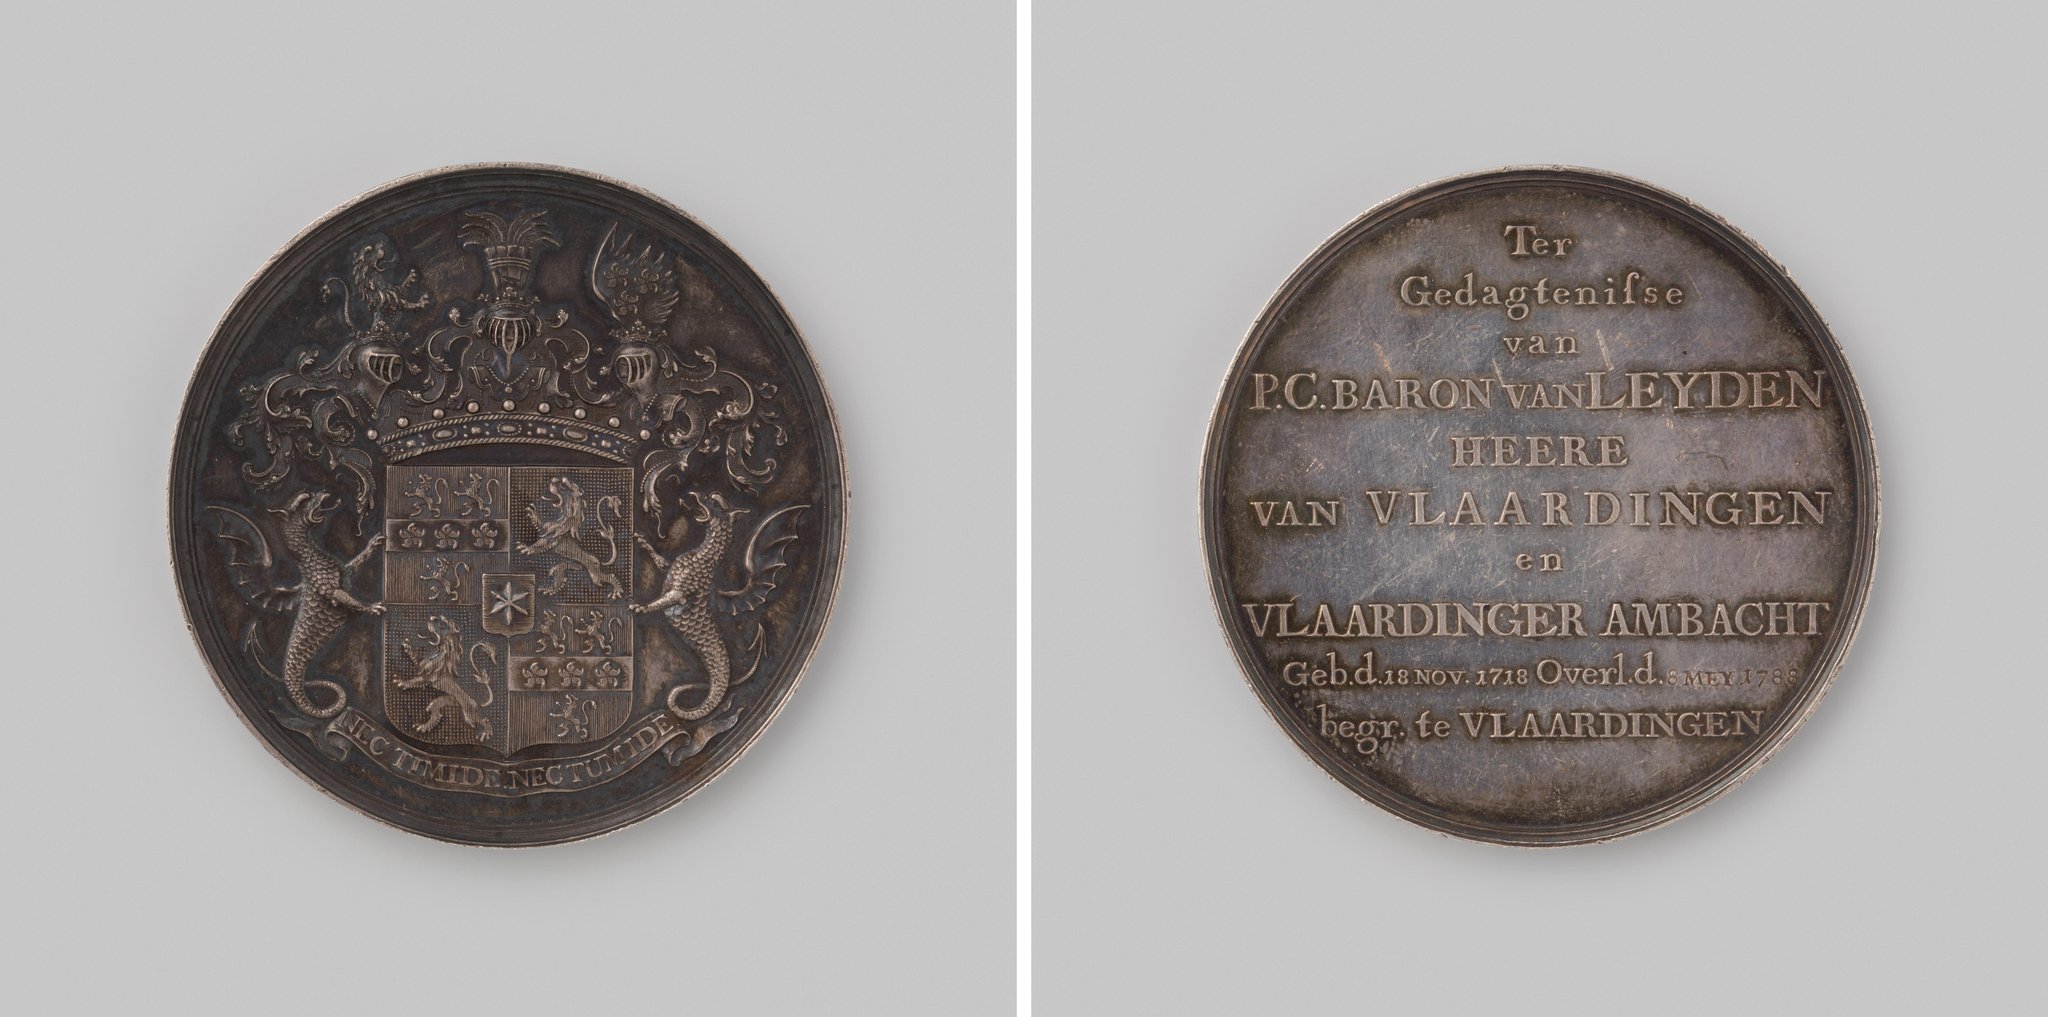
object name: history medal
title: Overlijden van Pieter Cornelis Baron van Leyden te Vlaardingen 1788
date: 1788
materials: silver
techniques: pressing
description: Zilveren penning, op de voorzijde het wapenschild van Van Leyden onder een drievoudig gehelmde kroon, met griffioenen als tenanten en onderaan een lint met wapenspreuk, op de keerzijde tien regels tekst.